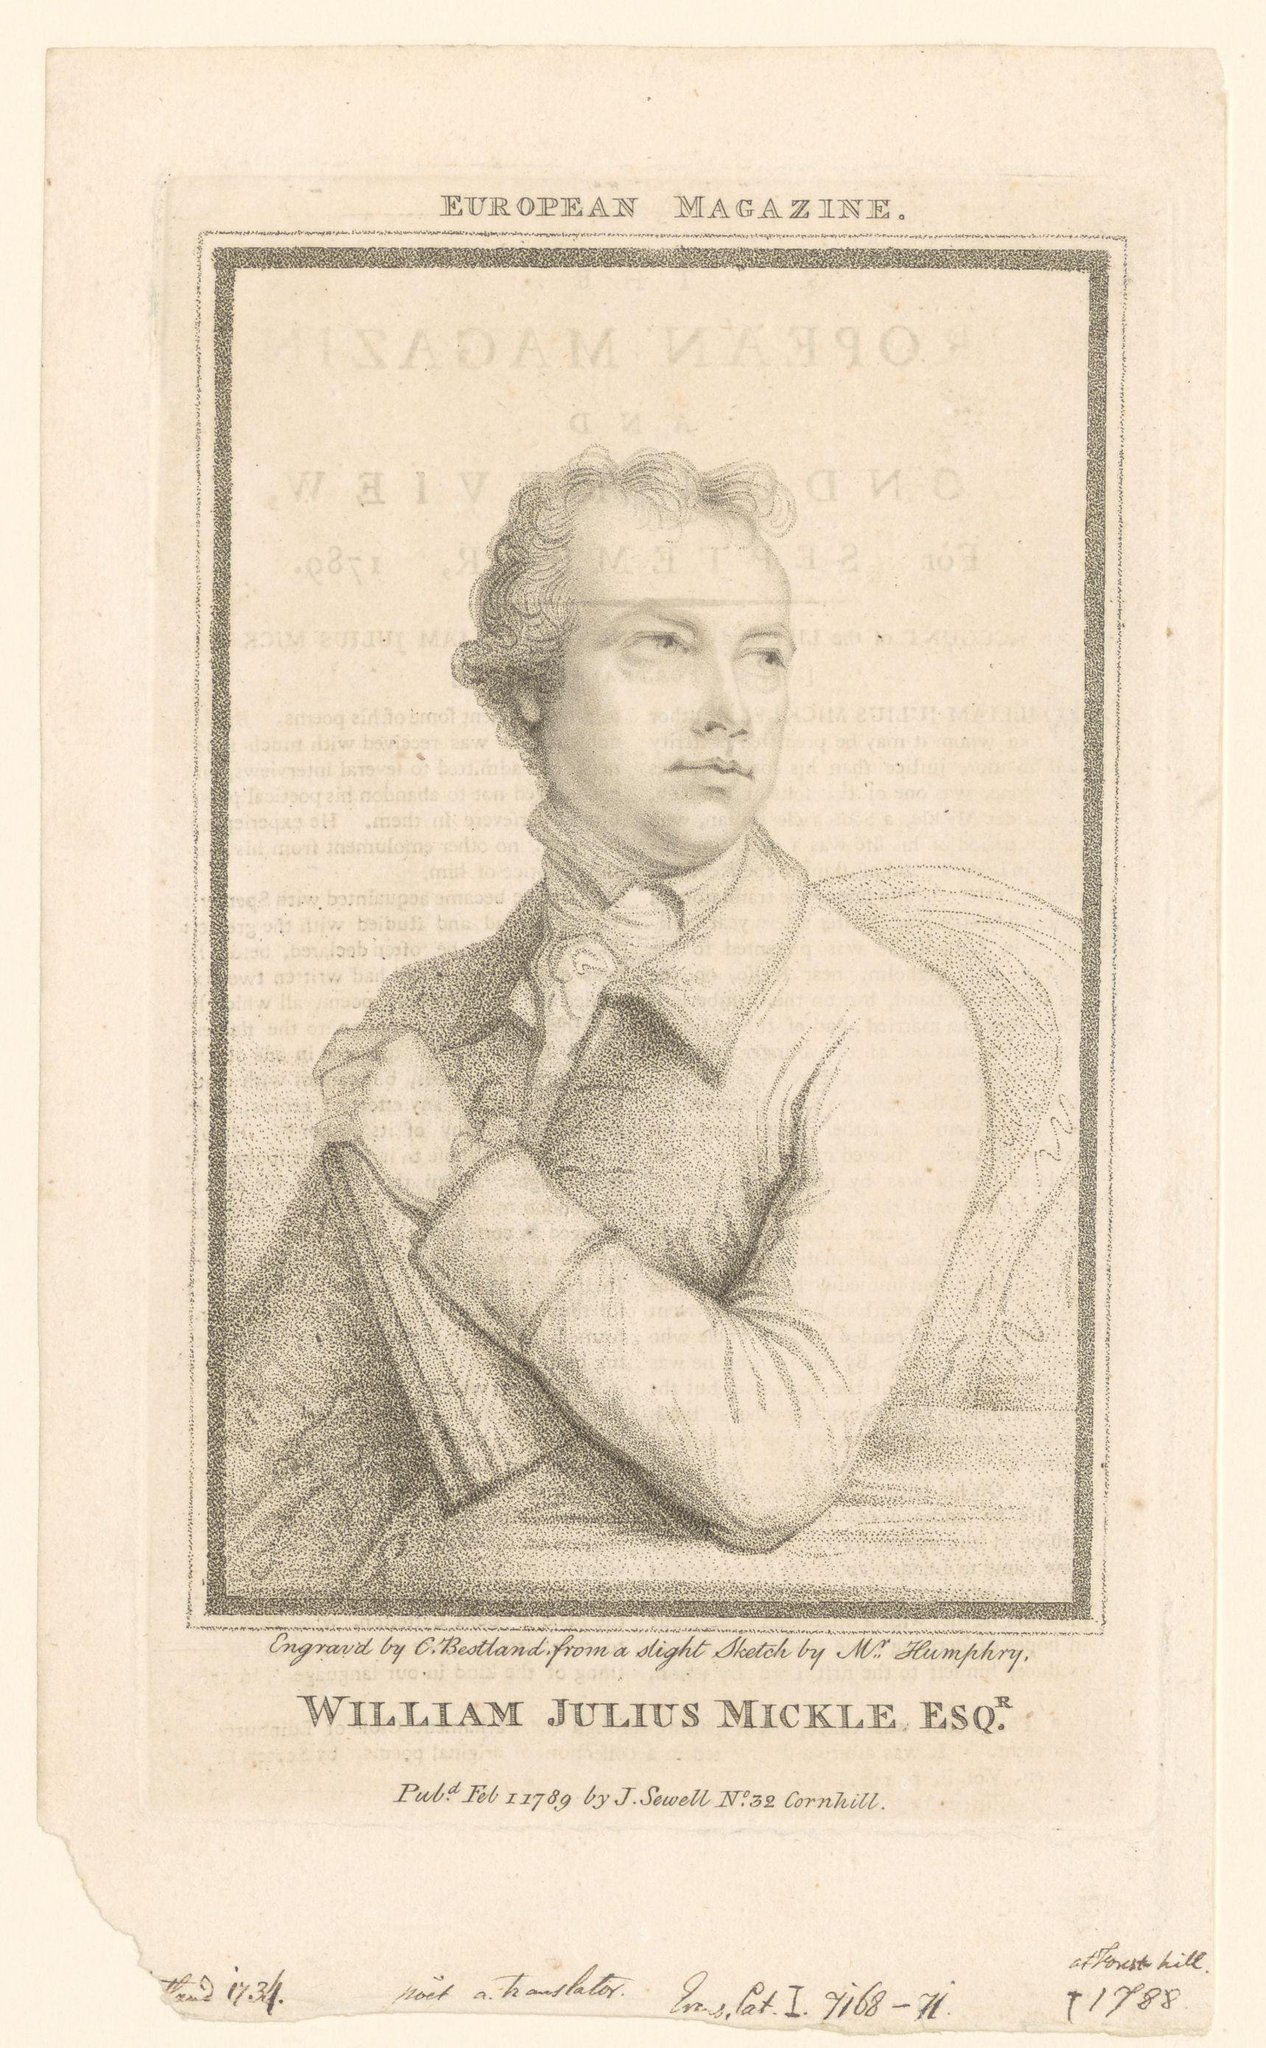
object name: print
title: William Julius Mickle ESQr.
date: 1702-1789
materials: paper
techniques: stippled etching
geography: london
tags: historical persons, writer, poet, author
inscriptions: inscription: ‘[...]land 1734 poet & translator (...)’, collector's mark: Lugt 2228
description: Prent uit: European Magazine, februari 1789.